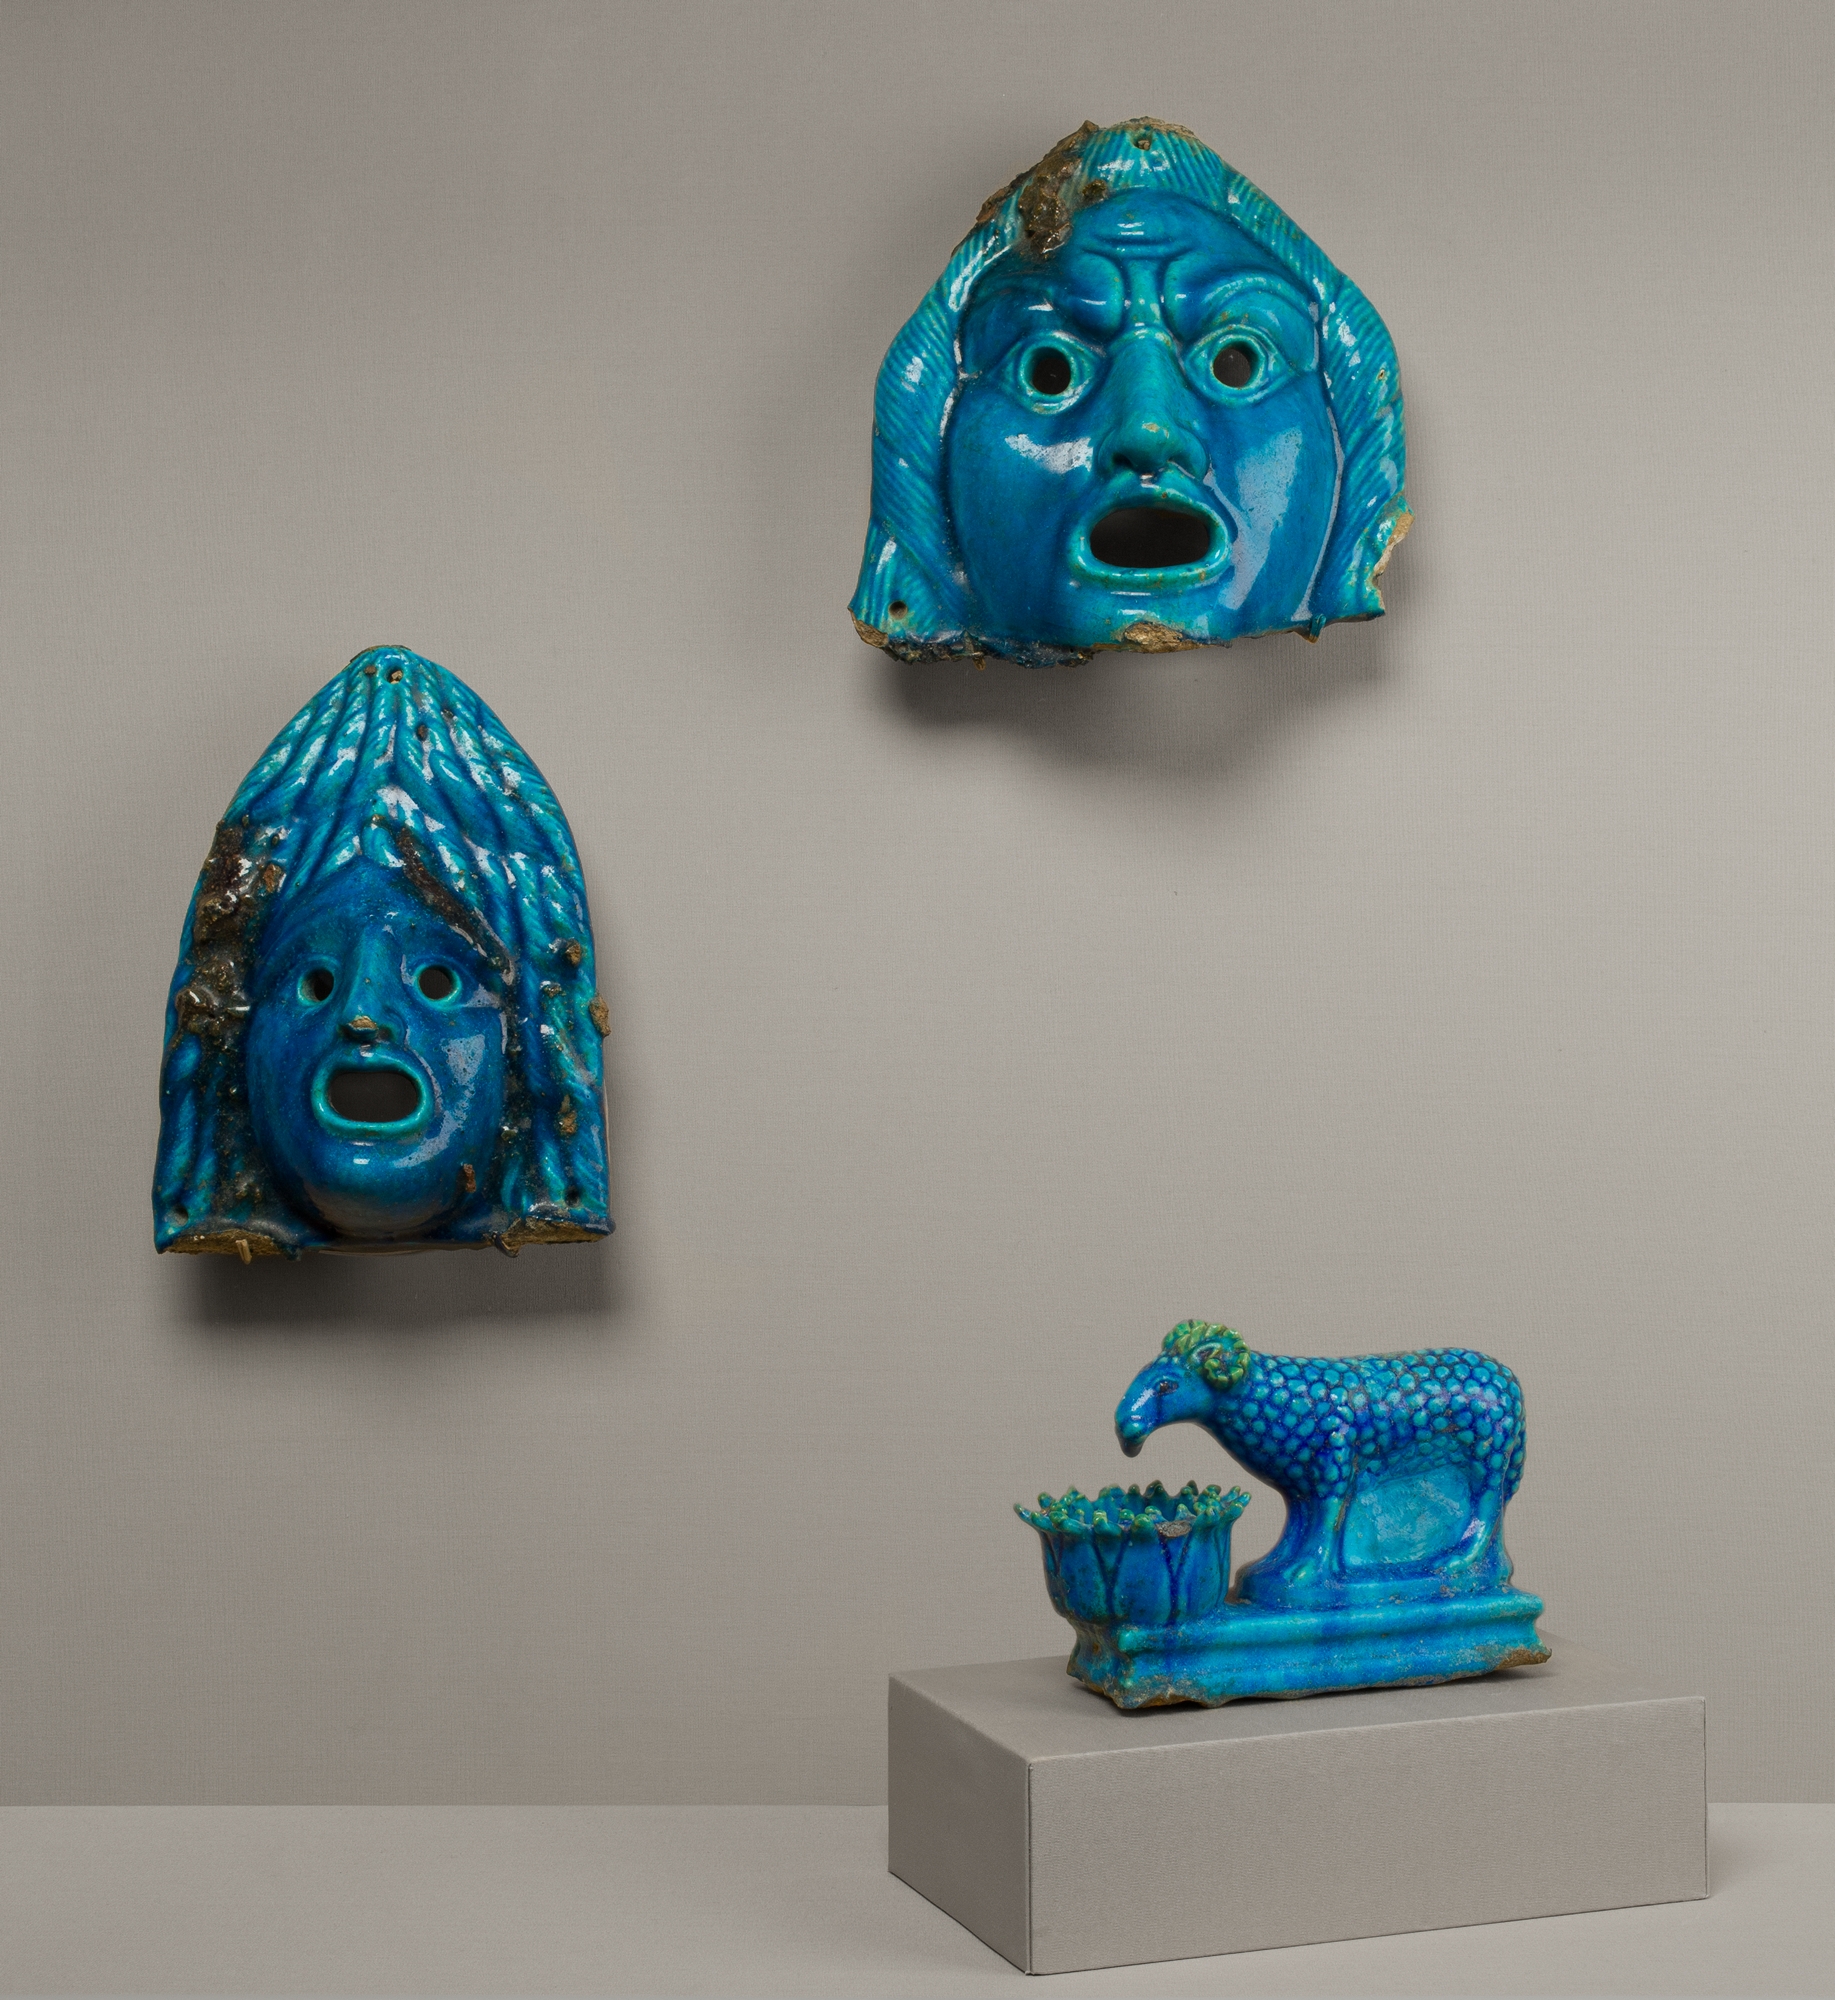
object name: mask, theatrical, ram vessel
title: Theatrical Masks and Ram Vessel for Offering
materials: faience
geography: fayum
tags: masks,rams